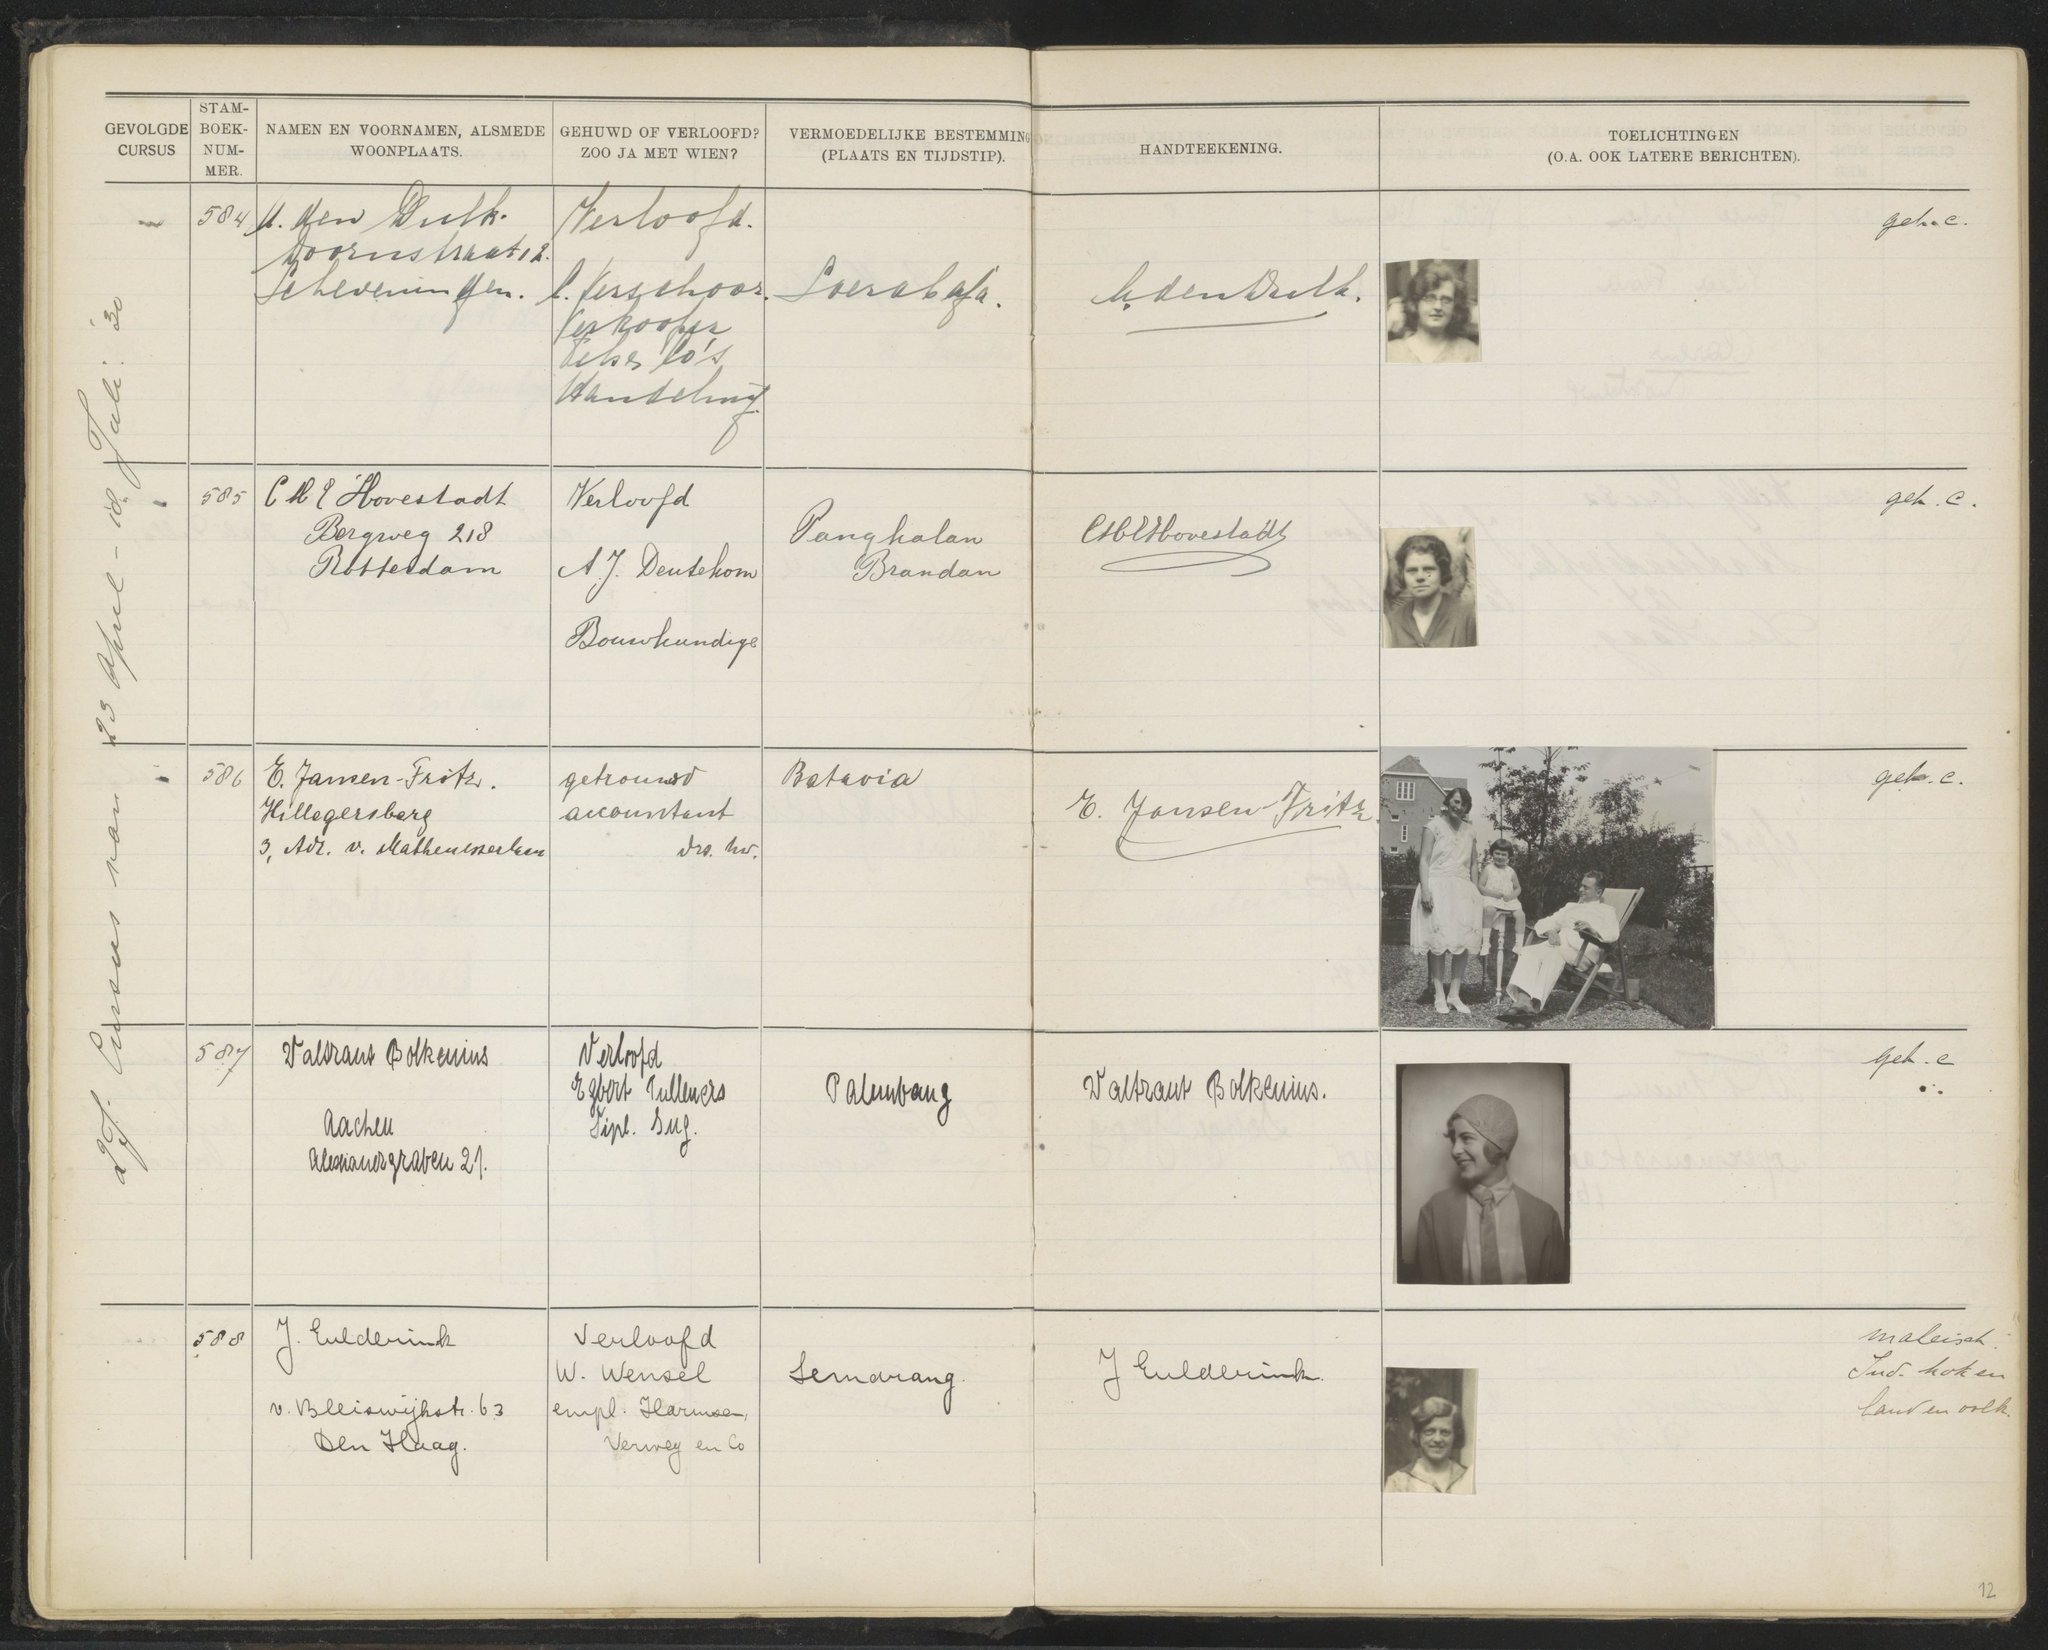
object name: album leaf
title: Blad 12 uit Stamboek van de leerlingen der Koloniale School voor Meisjes en Vrouwen te 's-Gravenhage deel II (1930-1949)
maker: Anonymous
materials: paper, photographic support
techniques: photography, printing, writing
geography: the hague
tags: further education (+ pupil), further education, the hague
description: Twee pagina's met gegevens van de deelnemers aan de 27e driemaandelijkse cursus van 23 april 1930 tot en met 18 juli 1930, stamboeknummers 584 tot en met 588. Onderdeel van Stamboek van de leerlingen der Koloniale School voor Meisjes en Vrouwen te 's-Gravenhage deel II (1930-1949).